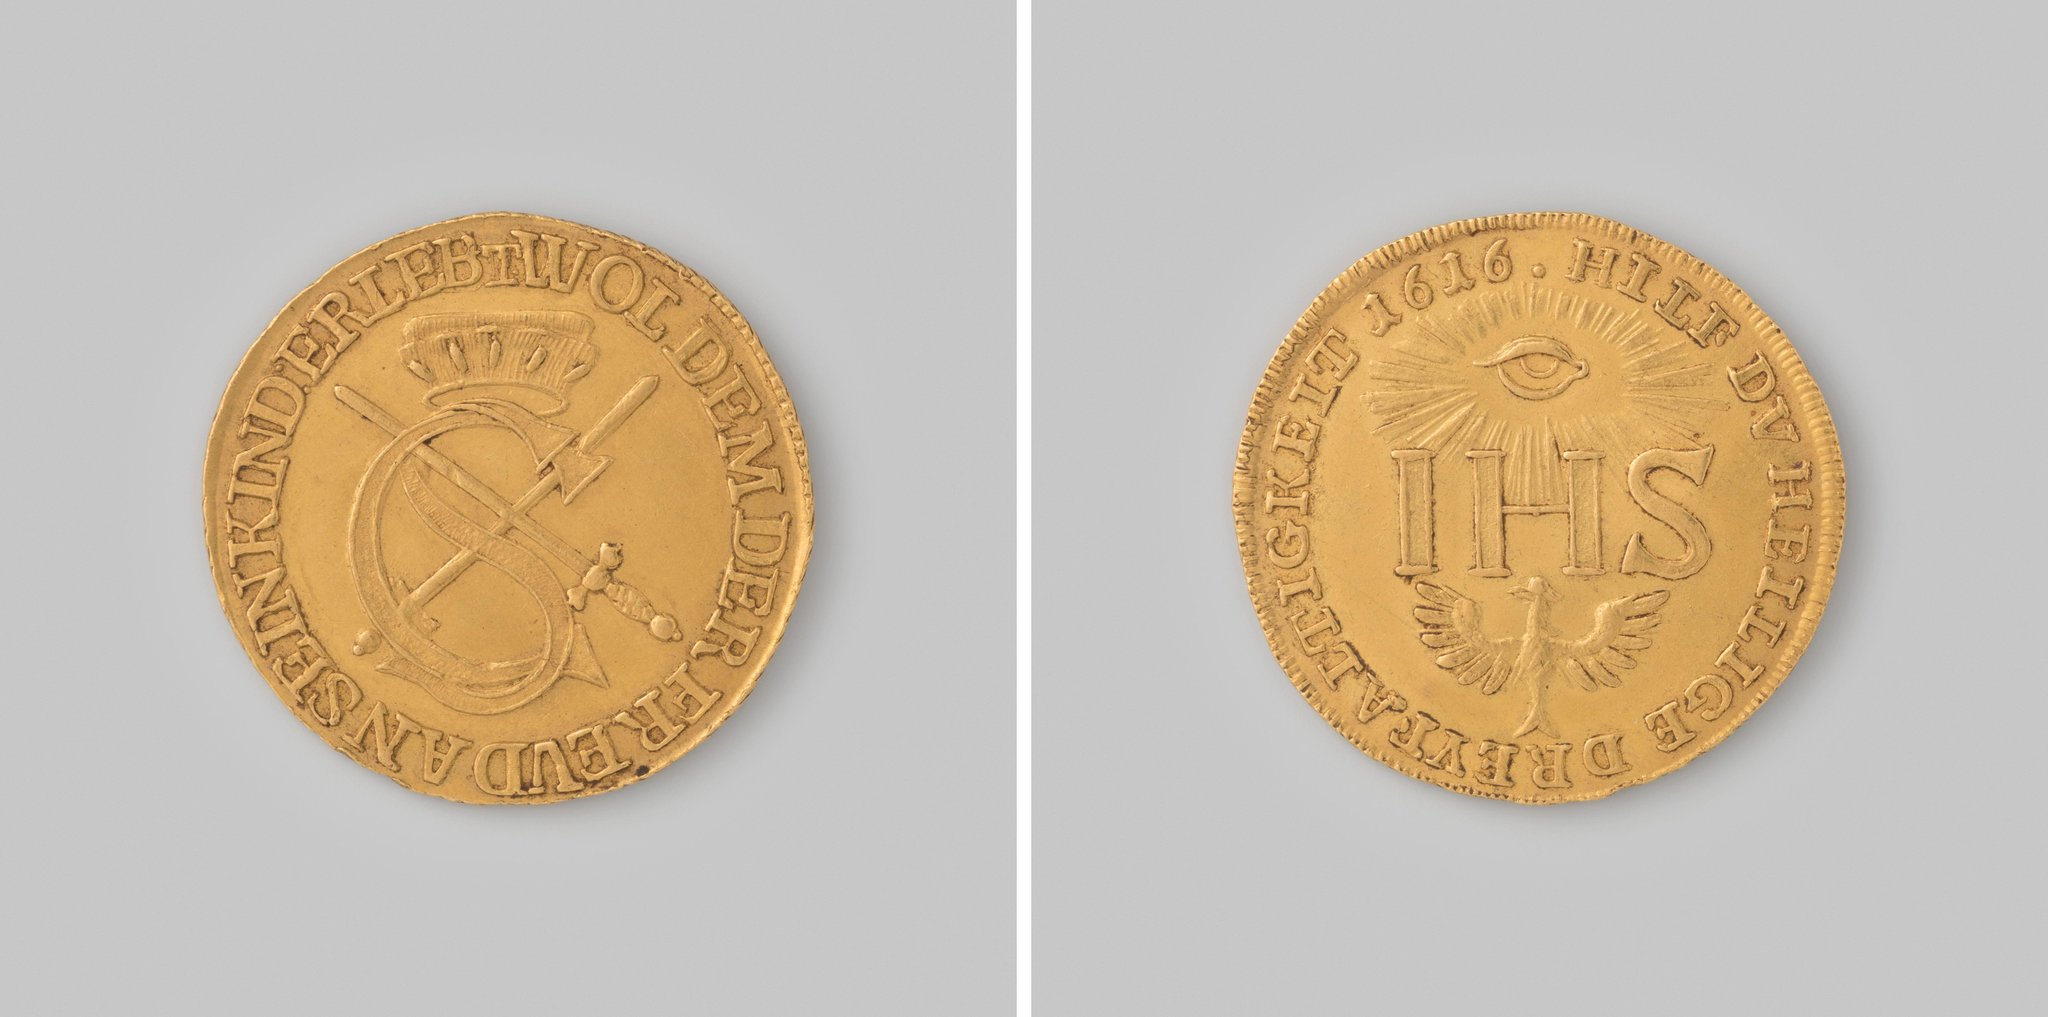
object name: ducat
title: Dukaat uit Saksen, Albertinische Linie, van Sophia, echtgenote van keurvorst Christian I, 1616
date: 1616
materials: gold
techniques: striking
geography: dresden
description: Gouden munt. Voorzijde: op twee gekruiste zwaarden gekroond monogram, bestaande uit de letters C en L . Keerzijde: op een regel de letters I,H en S. Daarboven het Alziend Oog en daaronder adelaar. Jaartal bovenaan in omschrift. Kabelrand. Vanwege omschrift op voorzijde kinderdukaat genoemd. Deze munt, ook Sophiendukat genaamd, is tot 1812 herhaaldelijk nageslagen.